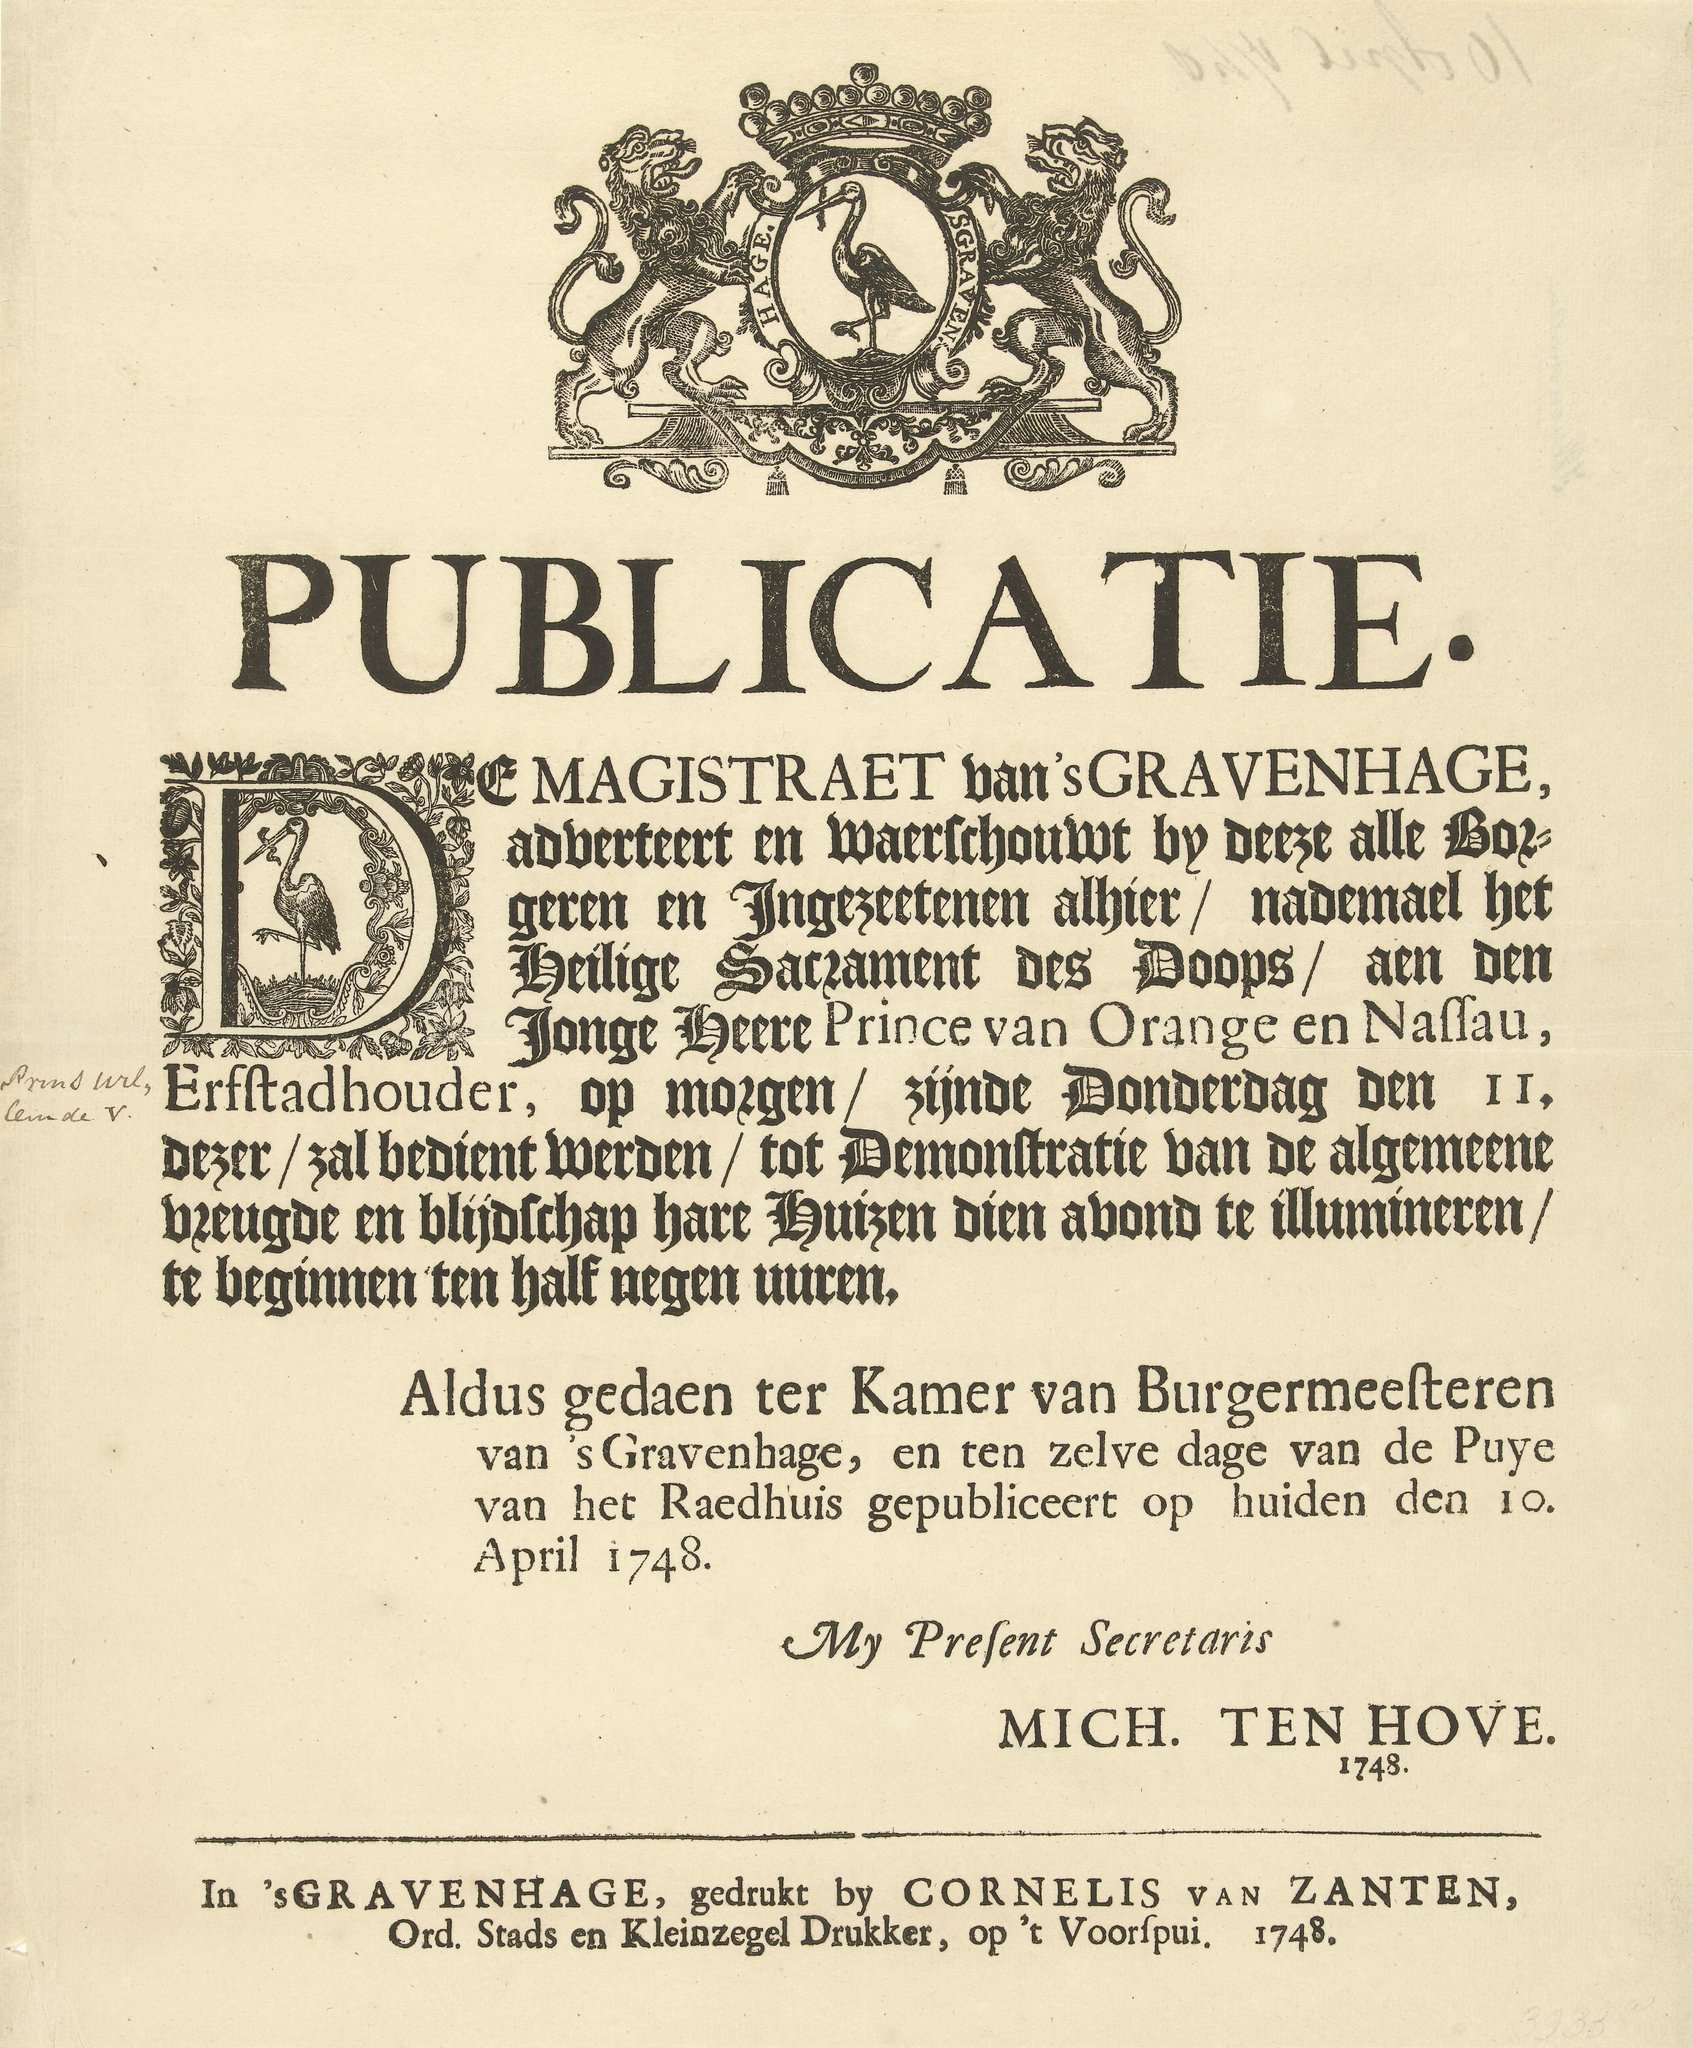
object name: text sheet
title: Oproep om te illumineren ter gelegenheid van de doop van prins Willem V, 1748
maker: cornelis van zanten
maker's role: publisher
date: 1748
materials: paper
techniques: letterpress printing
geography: the hague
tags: william v (prince of orange)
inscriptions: collector's mark: Lugt 2228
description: Tekstblad met de publicatie van de oproep van het stadsbestuur van Den Haag om vanaf half negen te illumineren ter gelegenheid van de doop van prins Willem V op 11 april 1748. Bovenaan een vignet met het stadswapen van Den Haag.